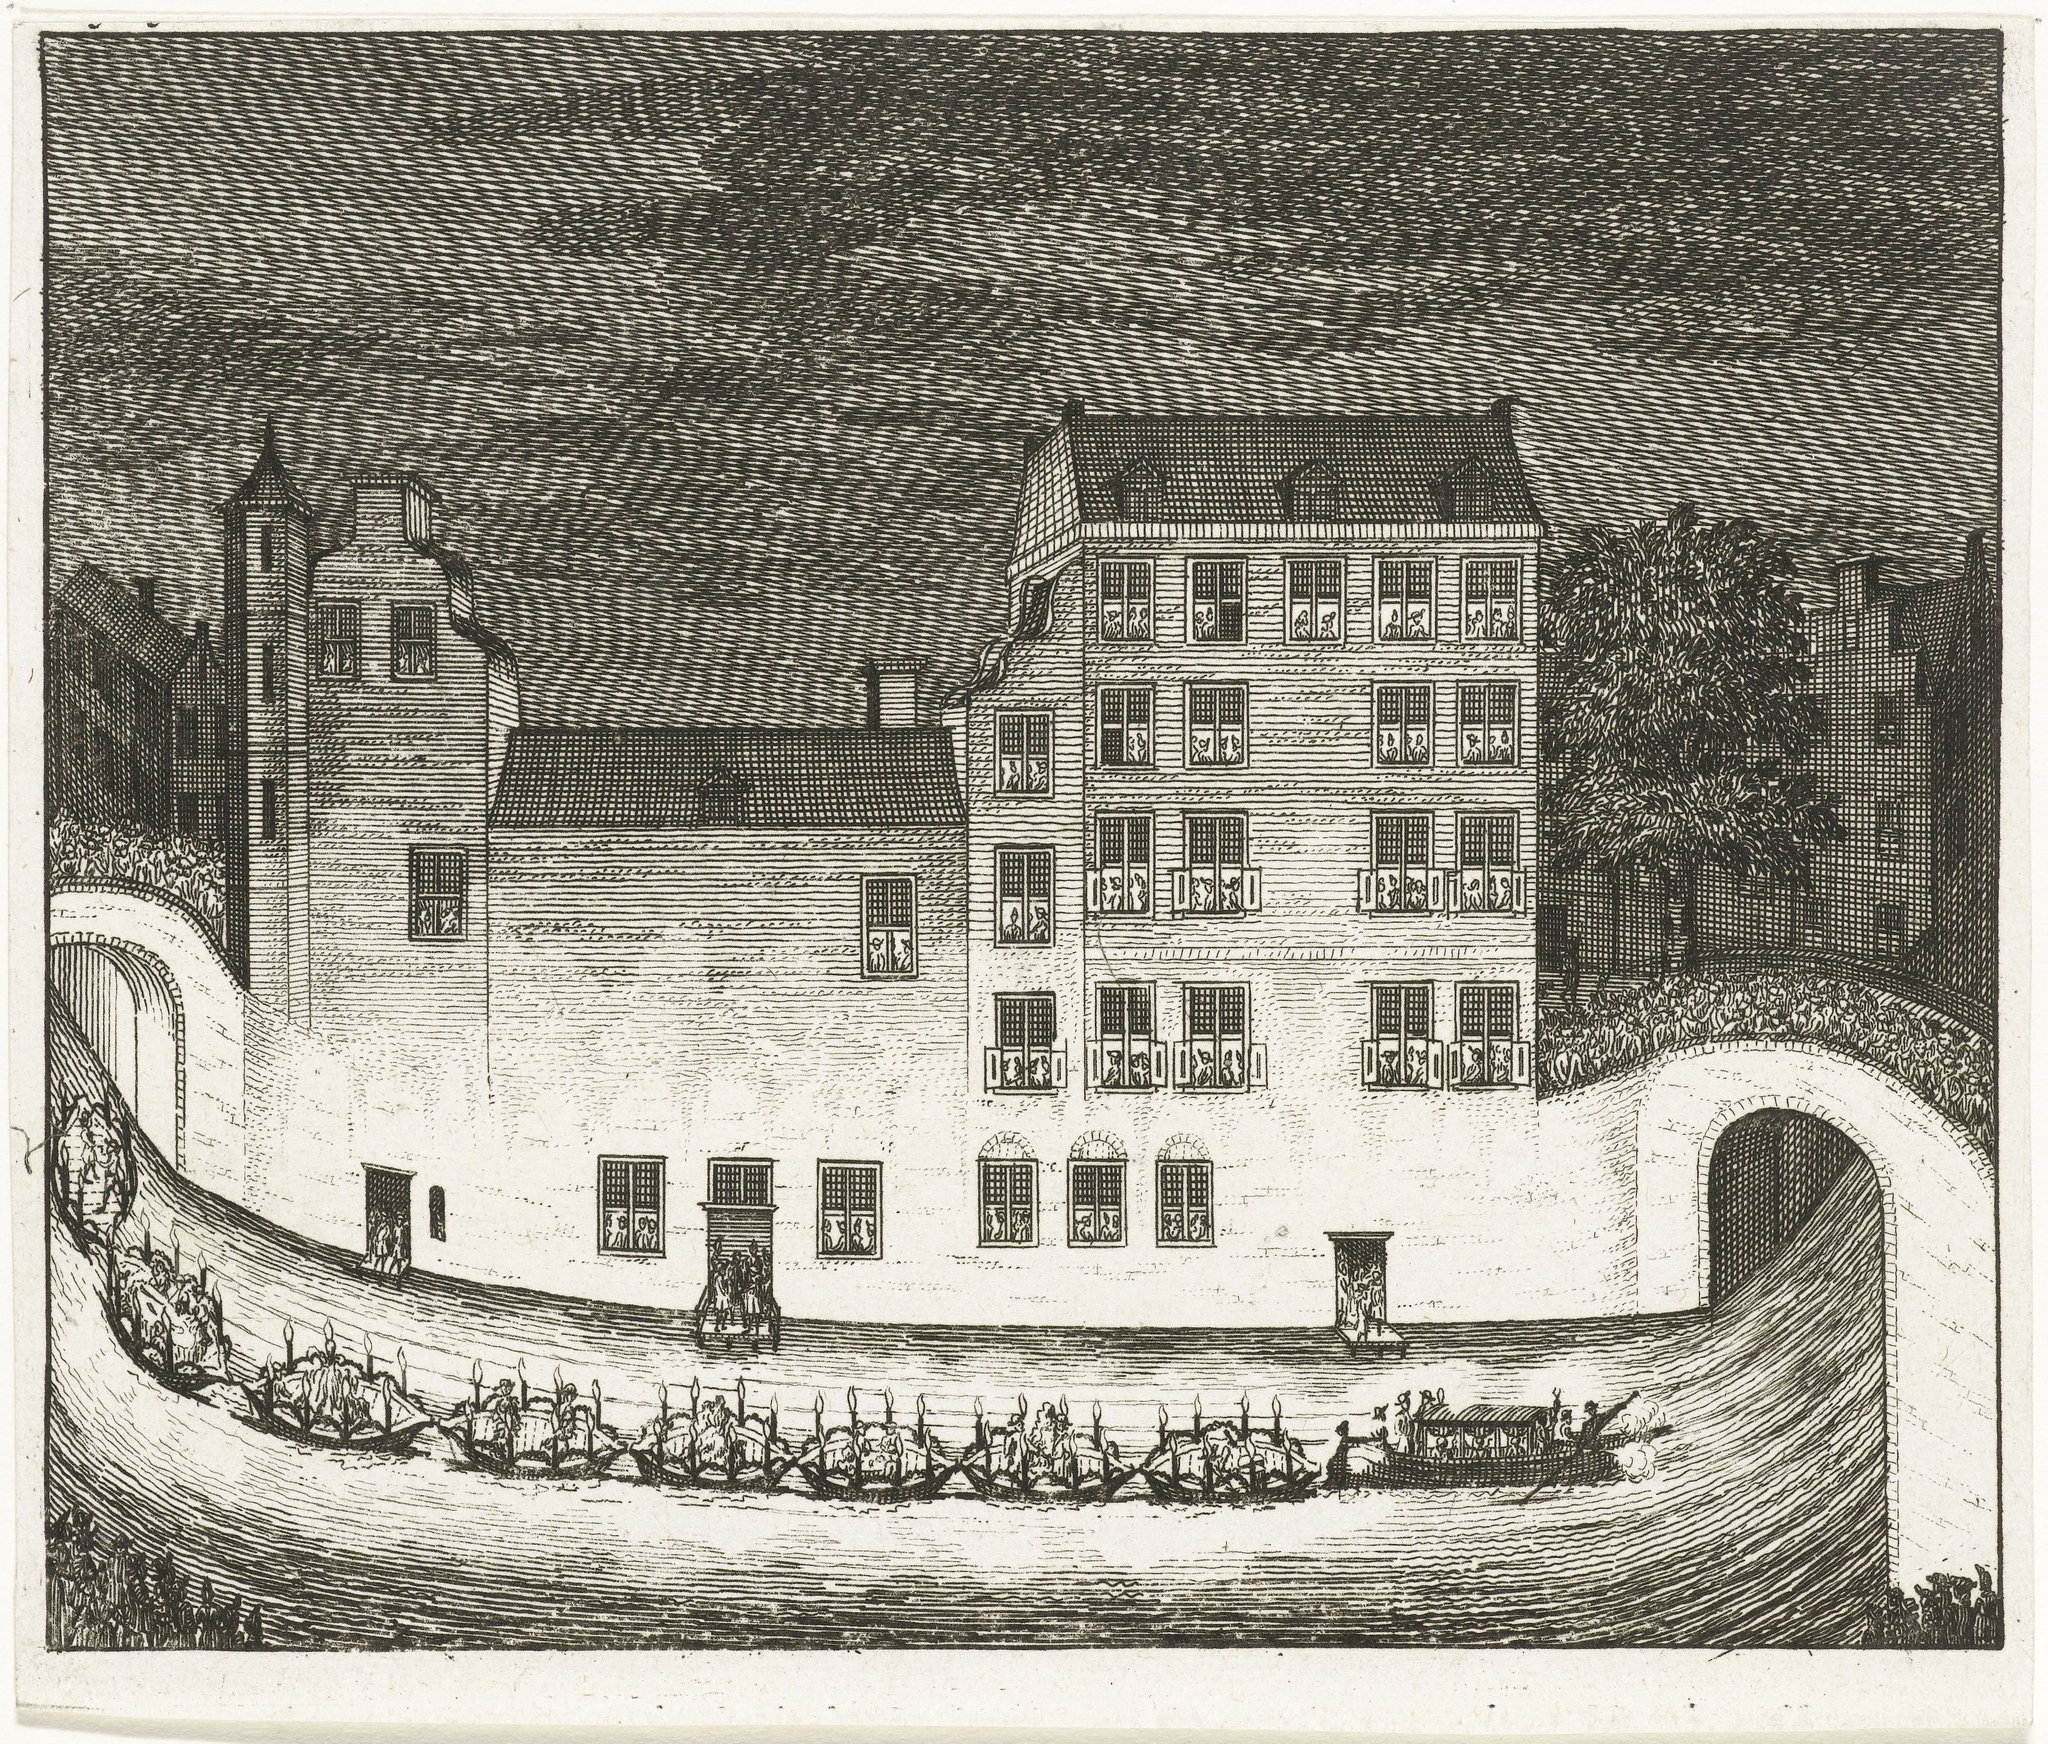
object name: print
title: Gondelvaart bij avond, 1714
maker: Anonymous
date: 1714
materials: paper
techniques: etching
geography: northern netherlands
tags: public festivities at birth of royal persons, utrecht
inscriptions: collector's mark: Lugt 2228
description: Avondlijke gondelvaart door de Nieuwe Gracht bij de Jansdam te Utrecht, 1714. Onderdeel van een groep van twaalf illustraties van de feestelijkheden georganiseerd in Utrecht in 1714 door de Portugese graaf Joao Gomes da Silva conde de Tarouca ter ere van de geboorte van twee Portugese prinsjes van koning Johan V.